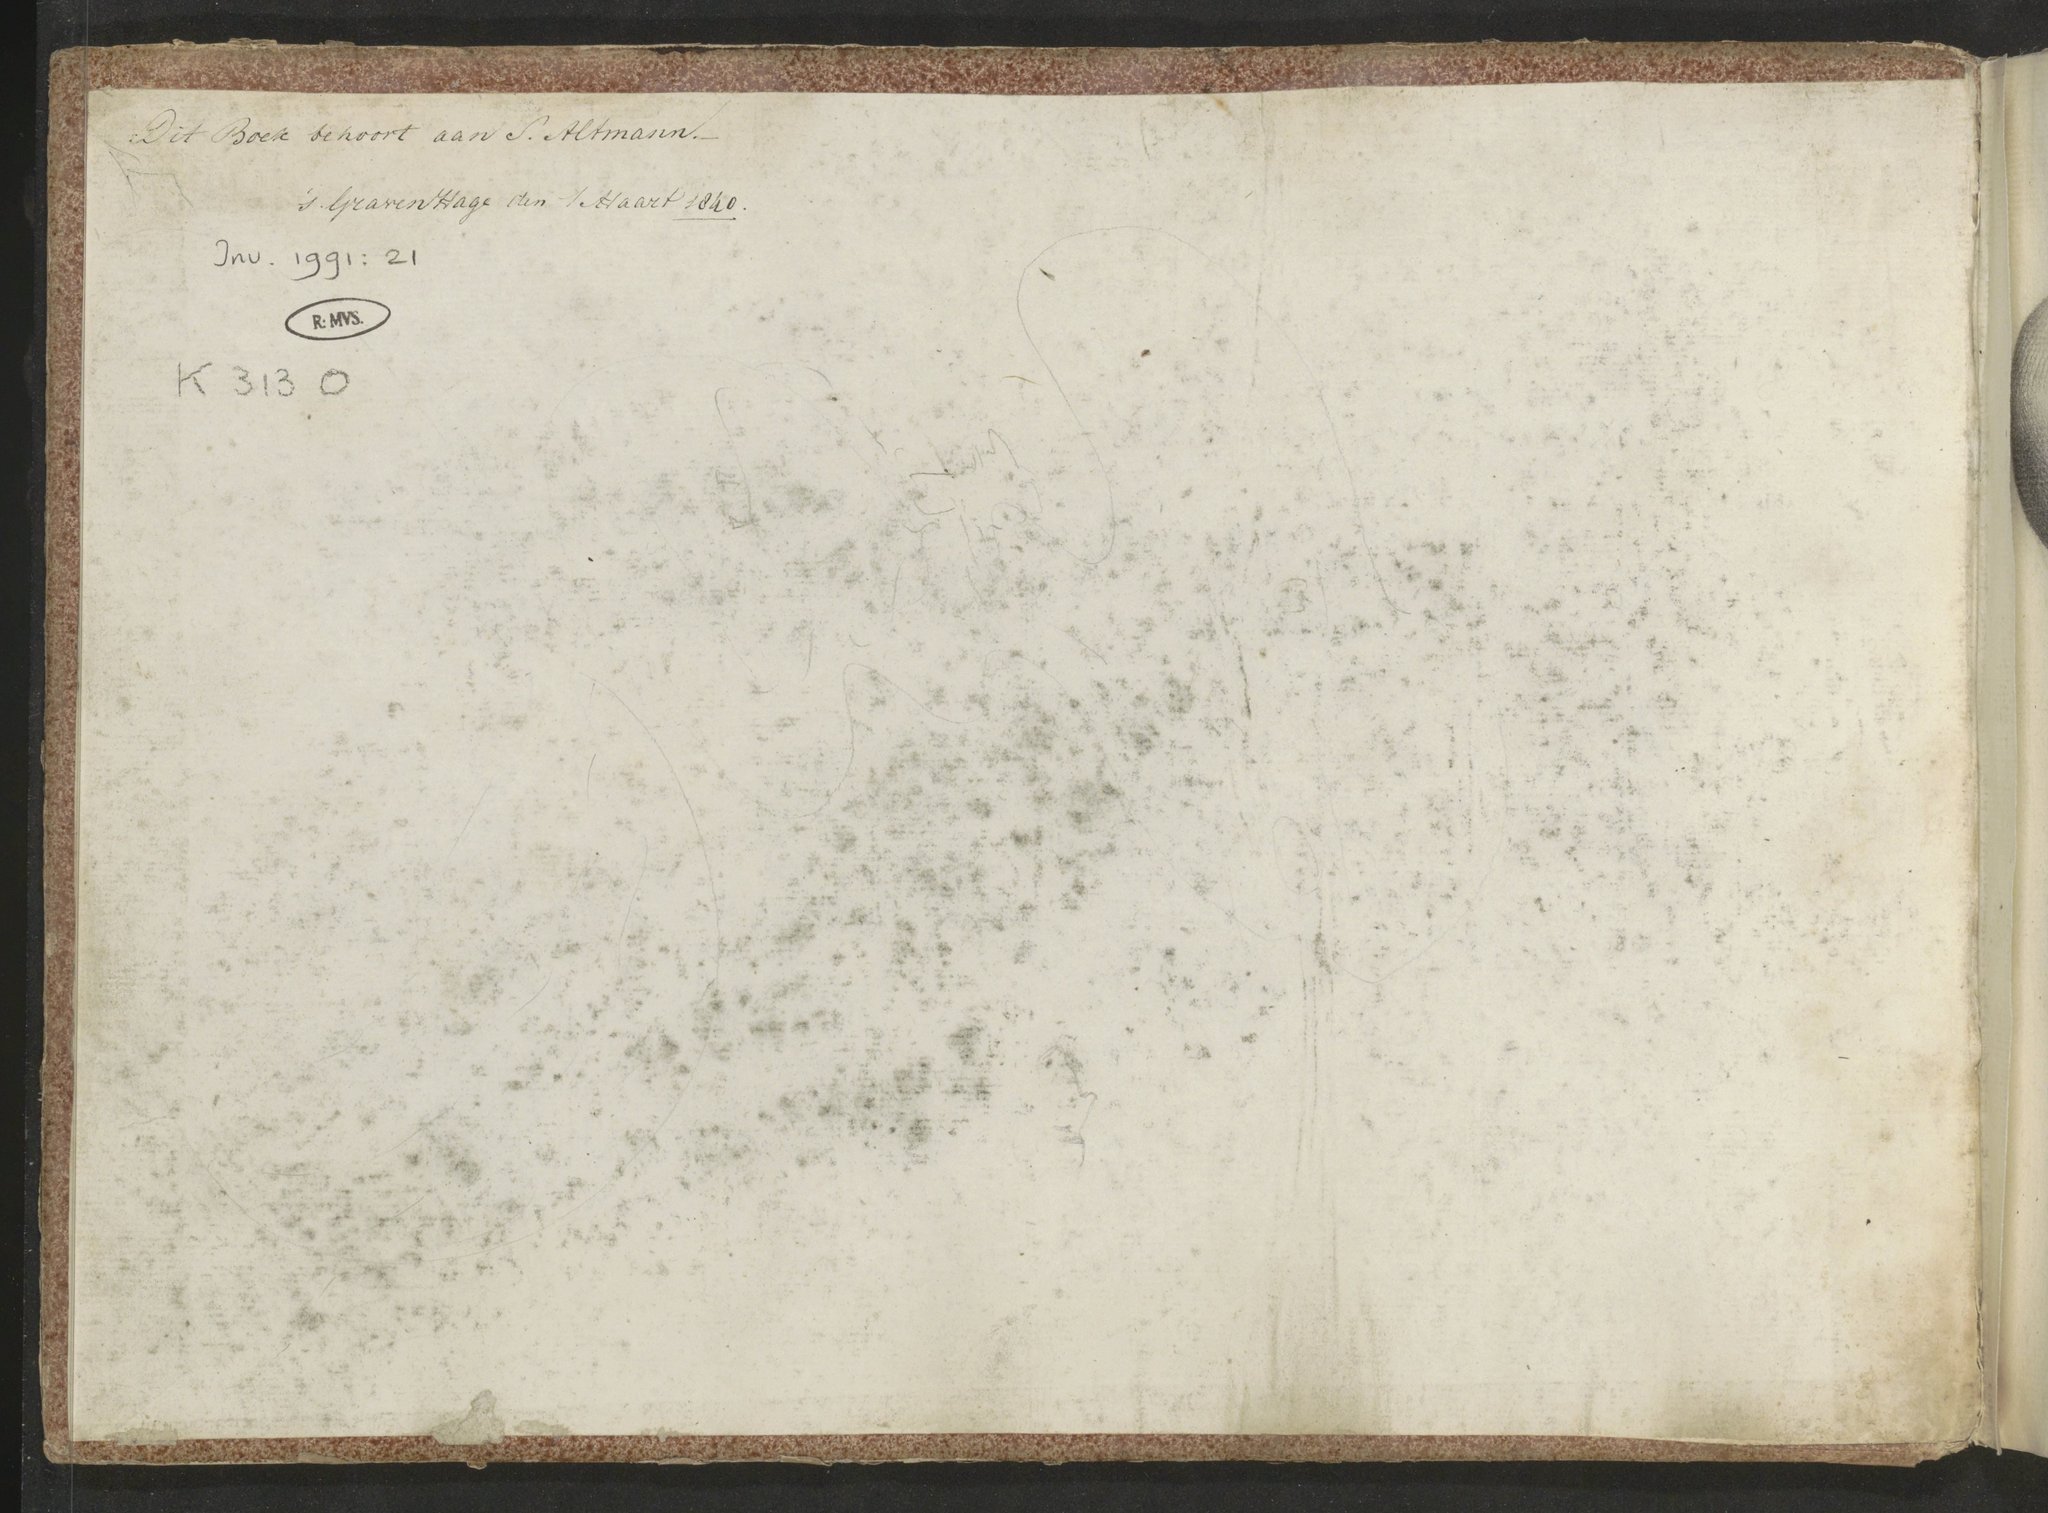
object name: sketchbook leaf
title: Studie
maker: s. altmann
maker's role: painter, print maker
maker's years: 1822-1890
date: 1803-1840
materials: paper, pencil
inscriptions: date and inscription: ‘Dit Boek behoort aan S. Altmann/ 's Gravenhage den 1 Maart 1840’, collector's mark: Lugt 22281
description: Voorste schutblad uit een schetsboek met 24 bladen.